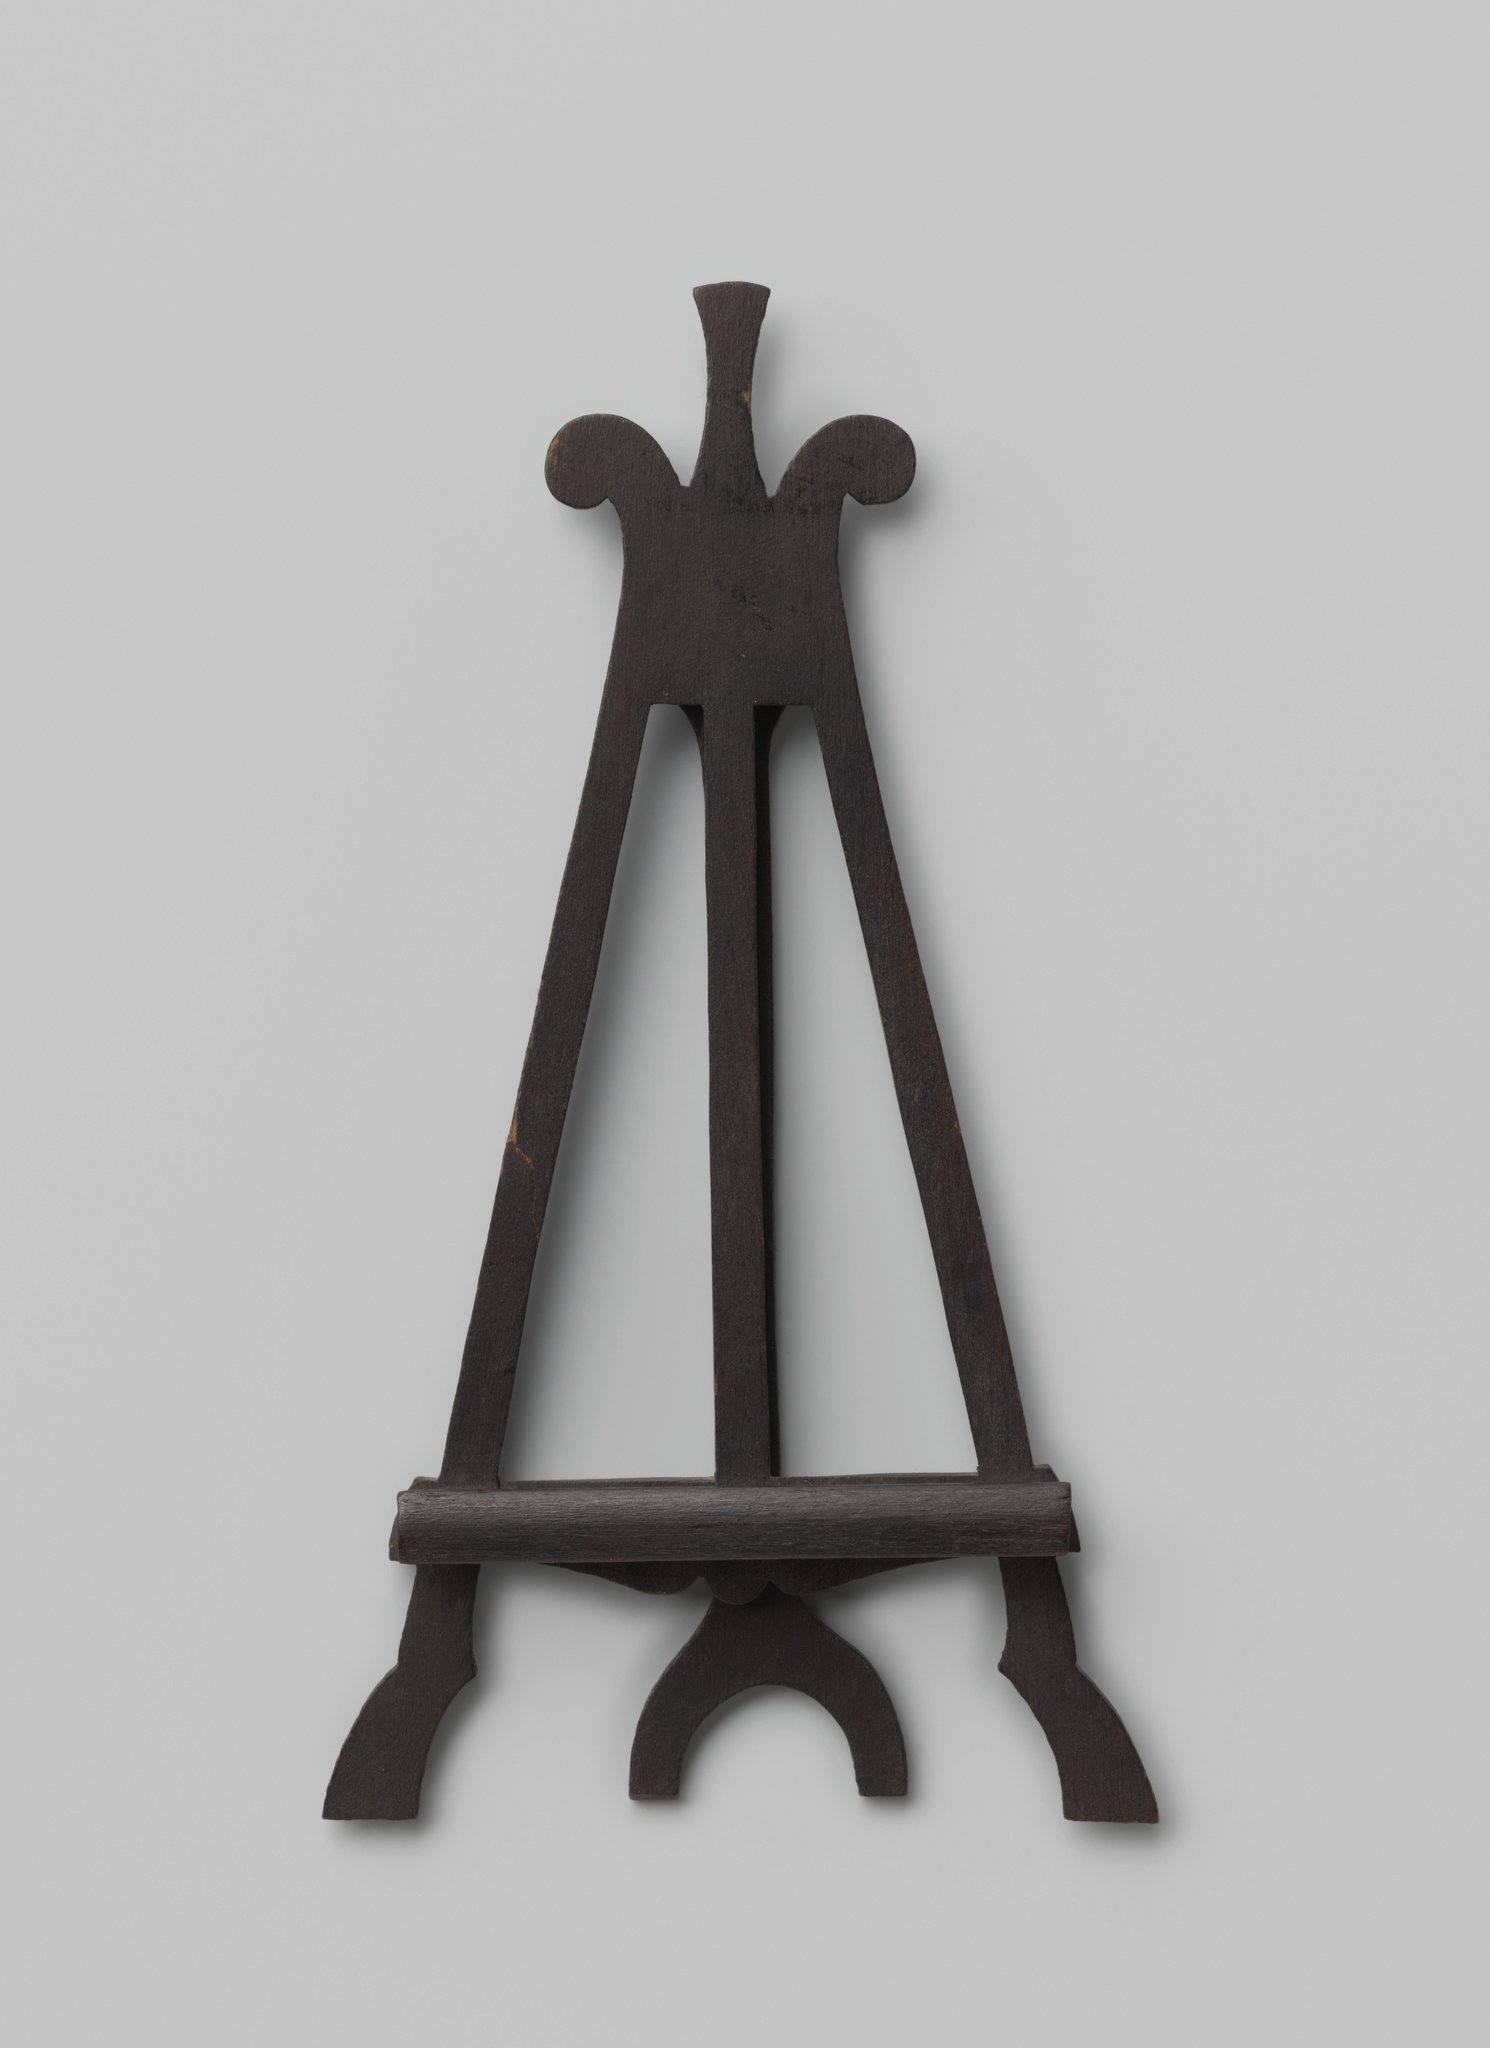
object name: standaard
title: Fotostandaard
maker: Anonymous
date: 1880-1900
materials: metal, wood